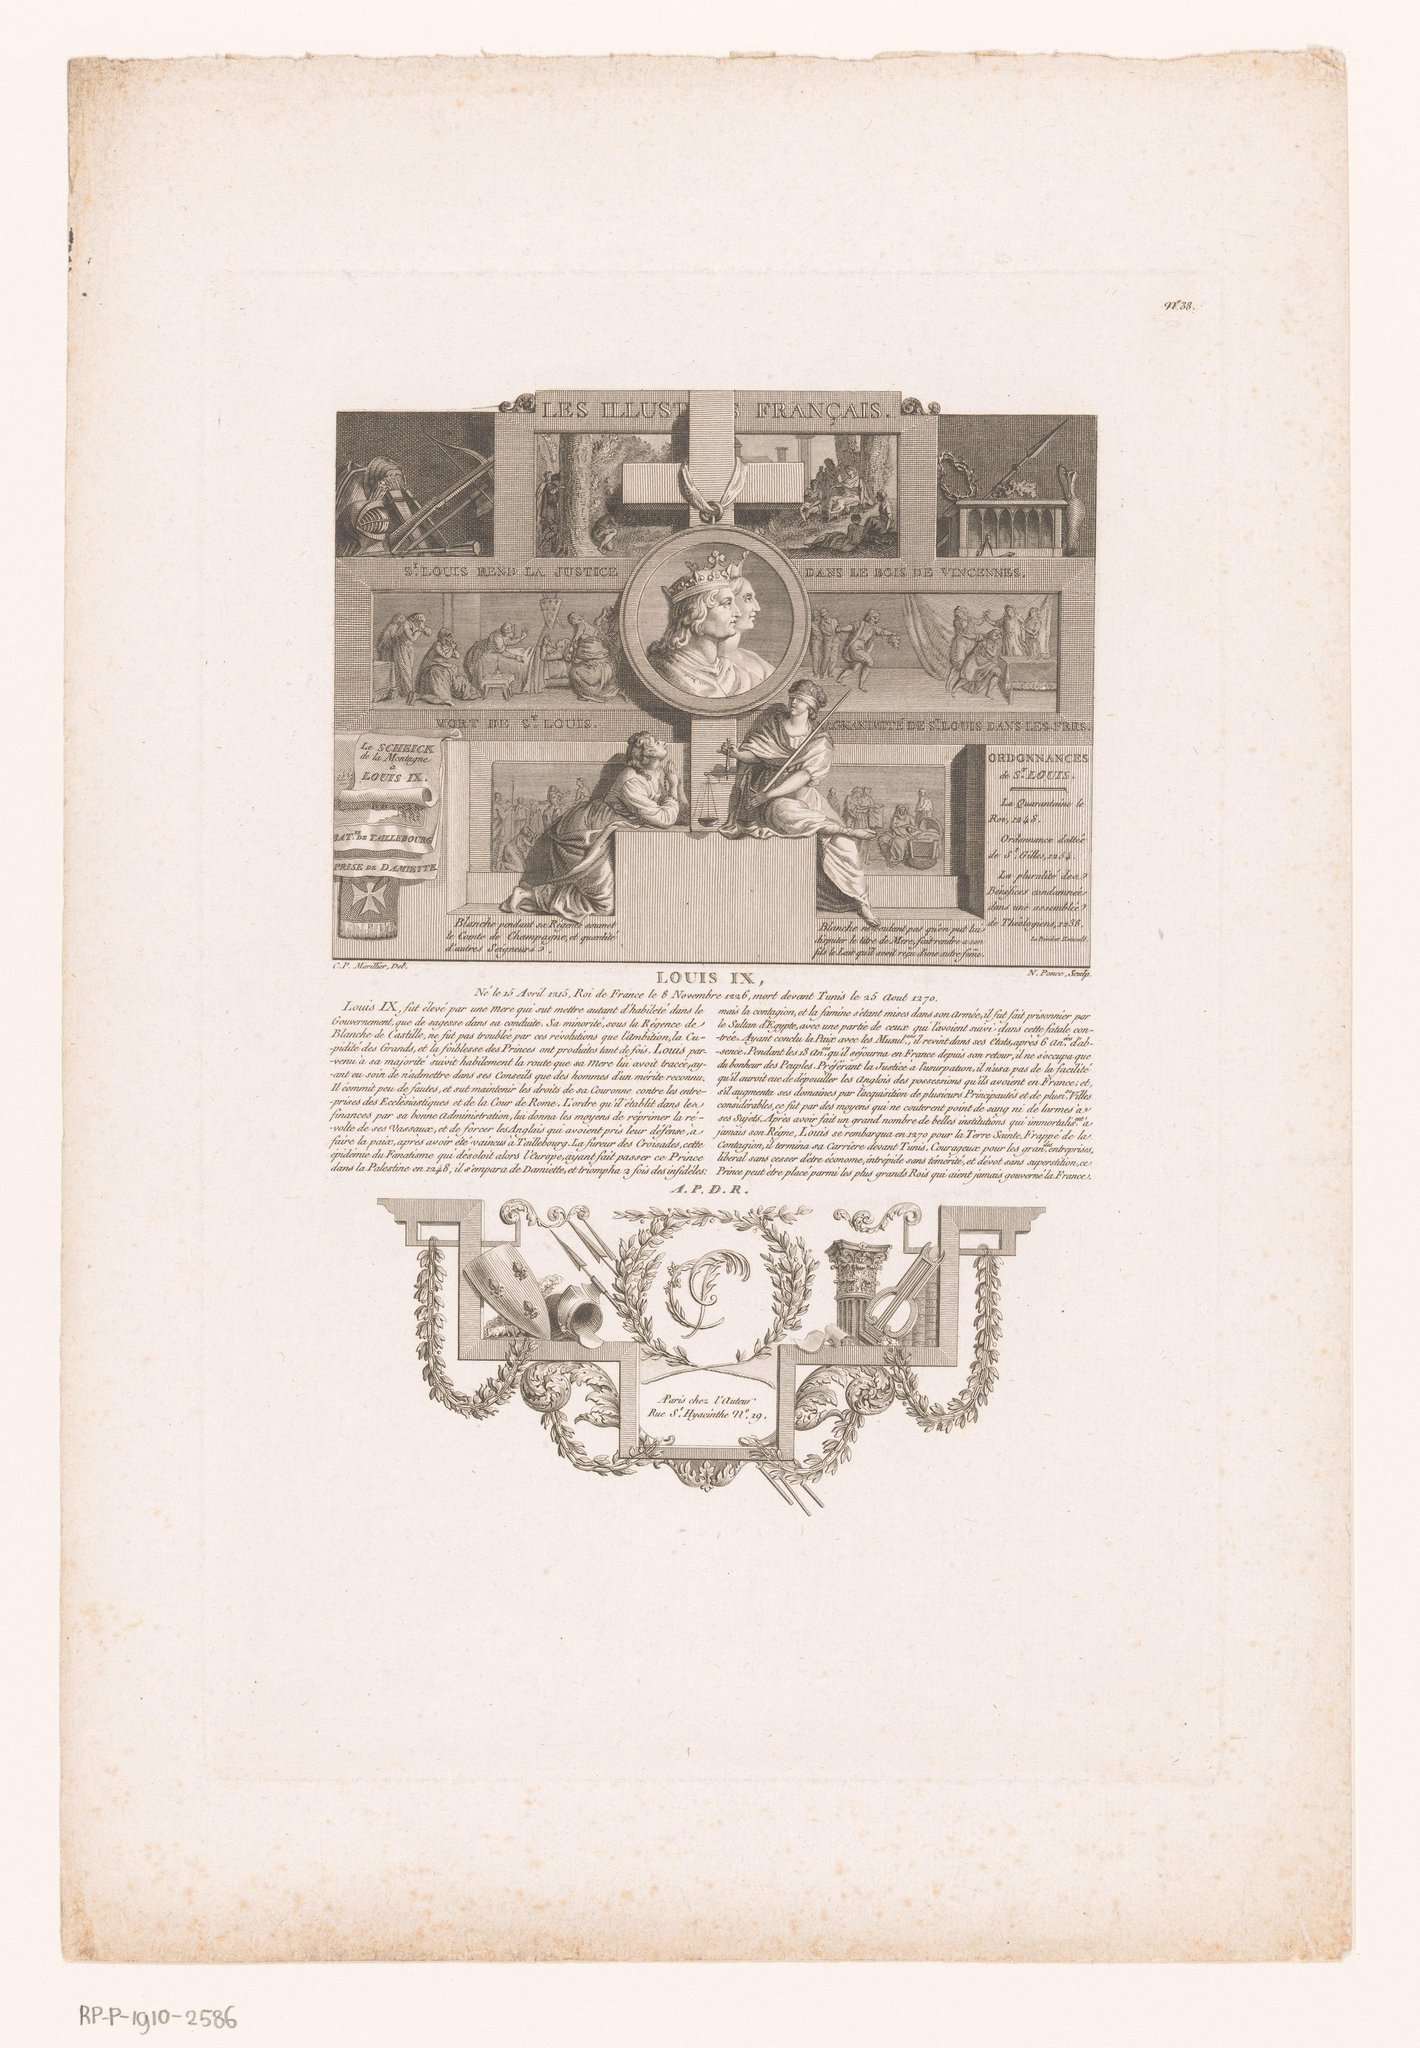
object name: print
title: Allegorisch portret van Lodewijk IX de Heilige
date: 1790-1816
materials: paper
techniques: engraving, etching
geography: paris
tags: historical persons, king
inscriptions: collector's mark: Lugt 2228